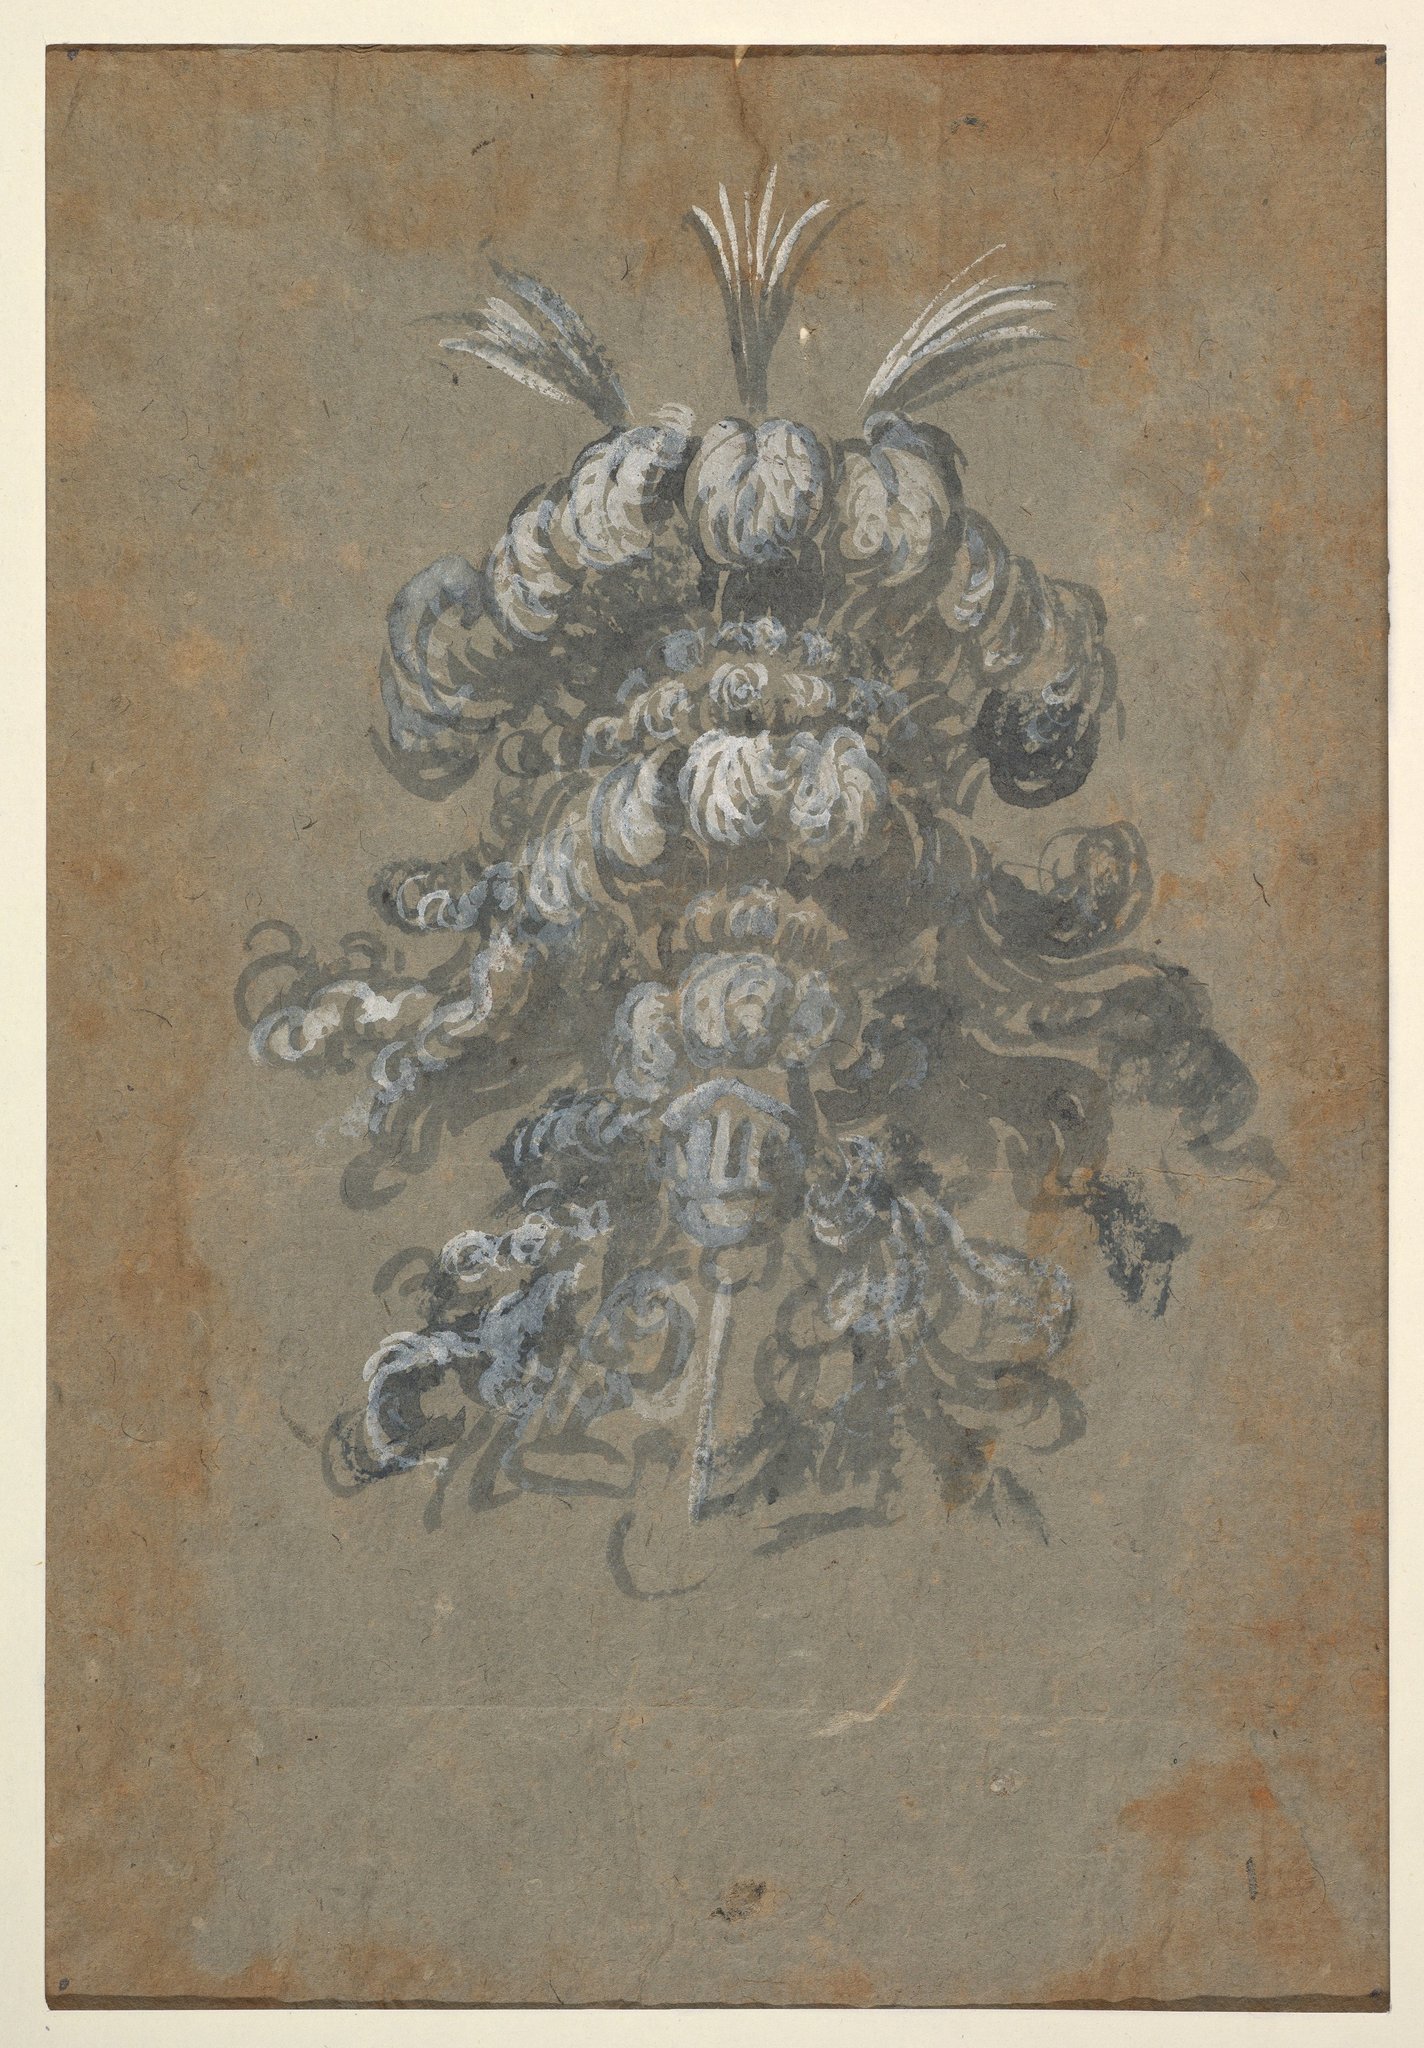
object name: collection ornament architecture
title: Design for a Lavish Headdress with Feathers on a Helmet (frontal view)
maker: baccio del bianco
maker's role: artist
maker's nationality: italian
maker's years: 1604-1656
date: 1620-1656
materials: gouache, watercolor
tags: feathers,headdresses